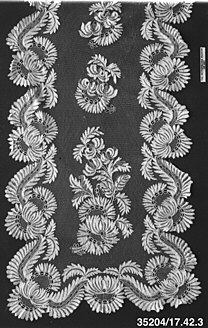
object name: fragment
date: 1801-1900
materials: lace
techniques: lace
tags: flowers,leaves